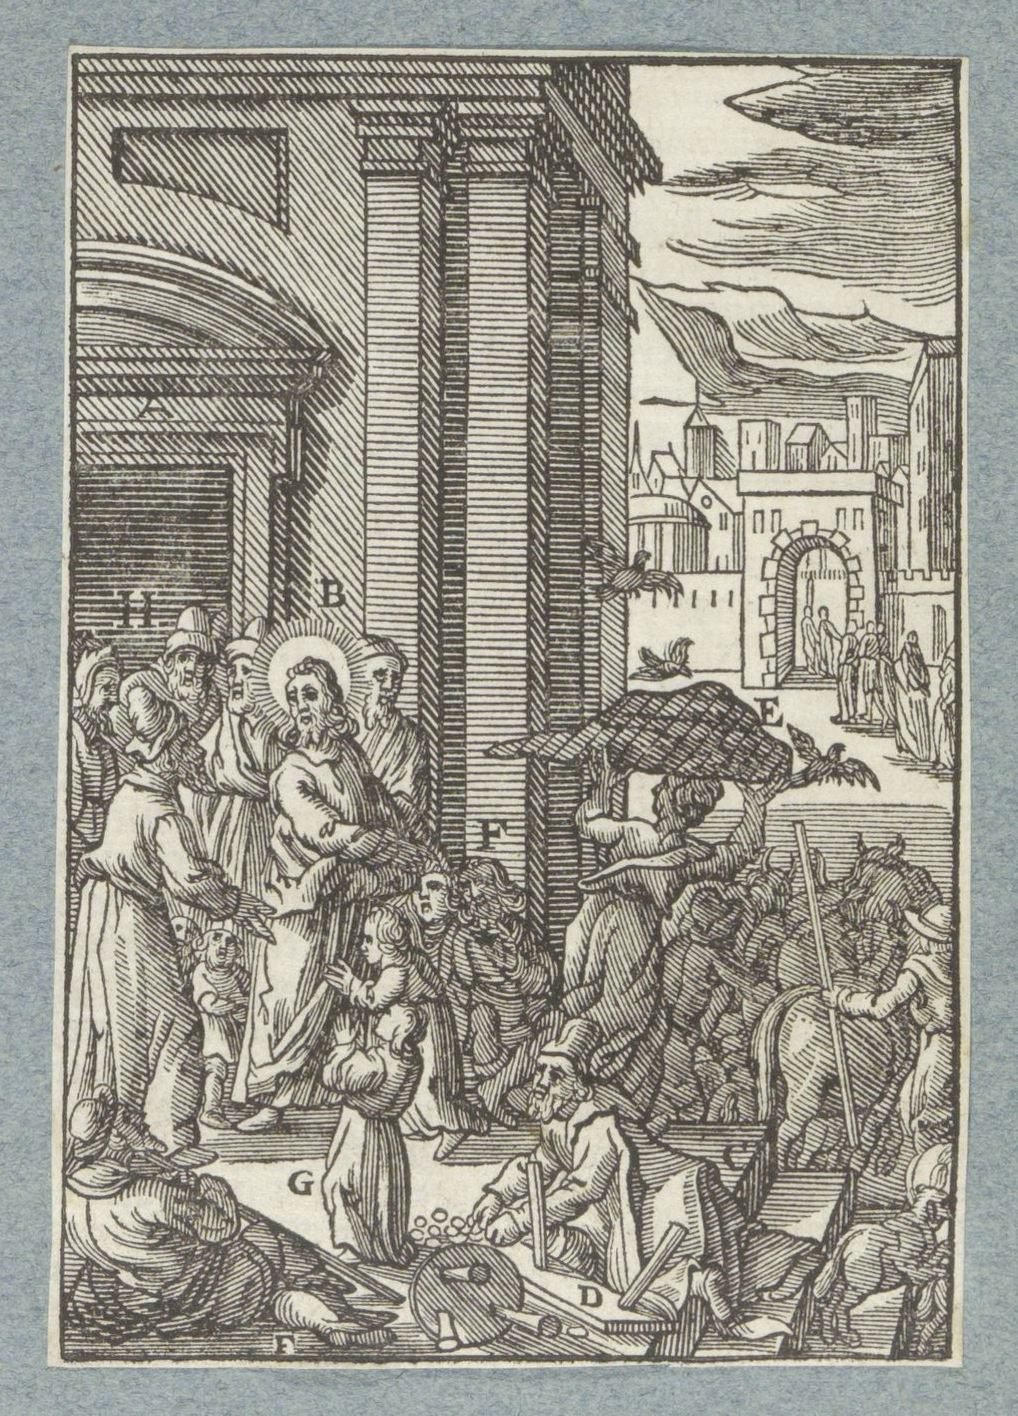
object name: print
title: Reiniging van de tempel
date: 1629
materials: paper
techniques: letterpress printing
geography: amsterdam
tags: purification of the temple ('first' and 'second'): christ driving the money-changers from the temple with a whip (matthew 21:12-13; mark 11:15-17; luke 19:45-46; john 12:12-19)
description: De prent is afkomstig uit een van de uitgaven van P.J. Paets uit Amsterdam. Ze wordt voor het eerst gebruikt in: Der Zielen Lust-hof. Leuven, I.Jacbosz voor P.J. Paets [= Amsterdam, P.J. Paets], 1629. De voorstelling is gekopieerd naar een prent van Antonie II Wierix voor: Nadal, Jerónimo. Evangelicae Historiae Imagines. Antwerpen, M. Nutius, 1593.